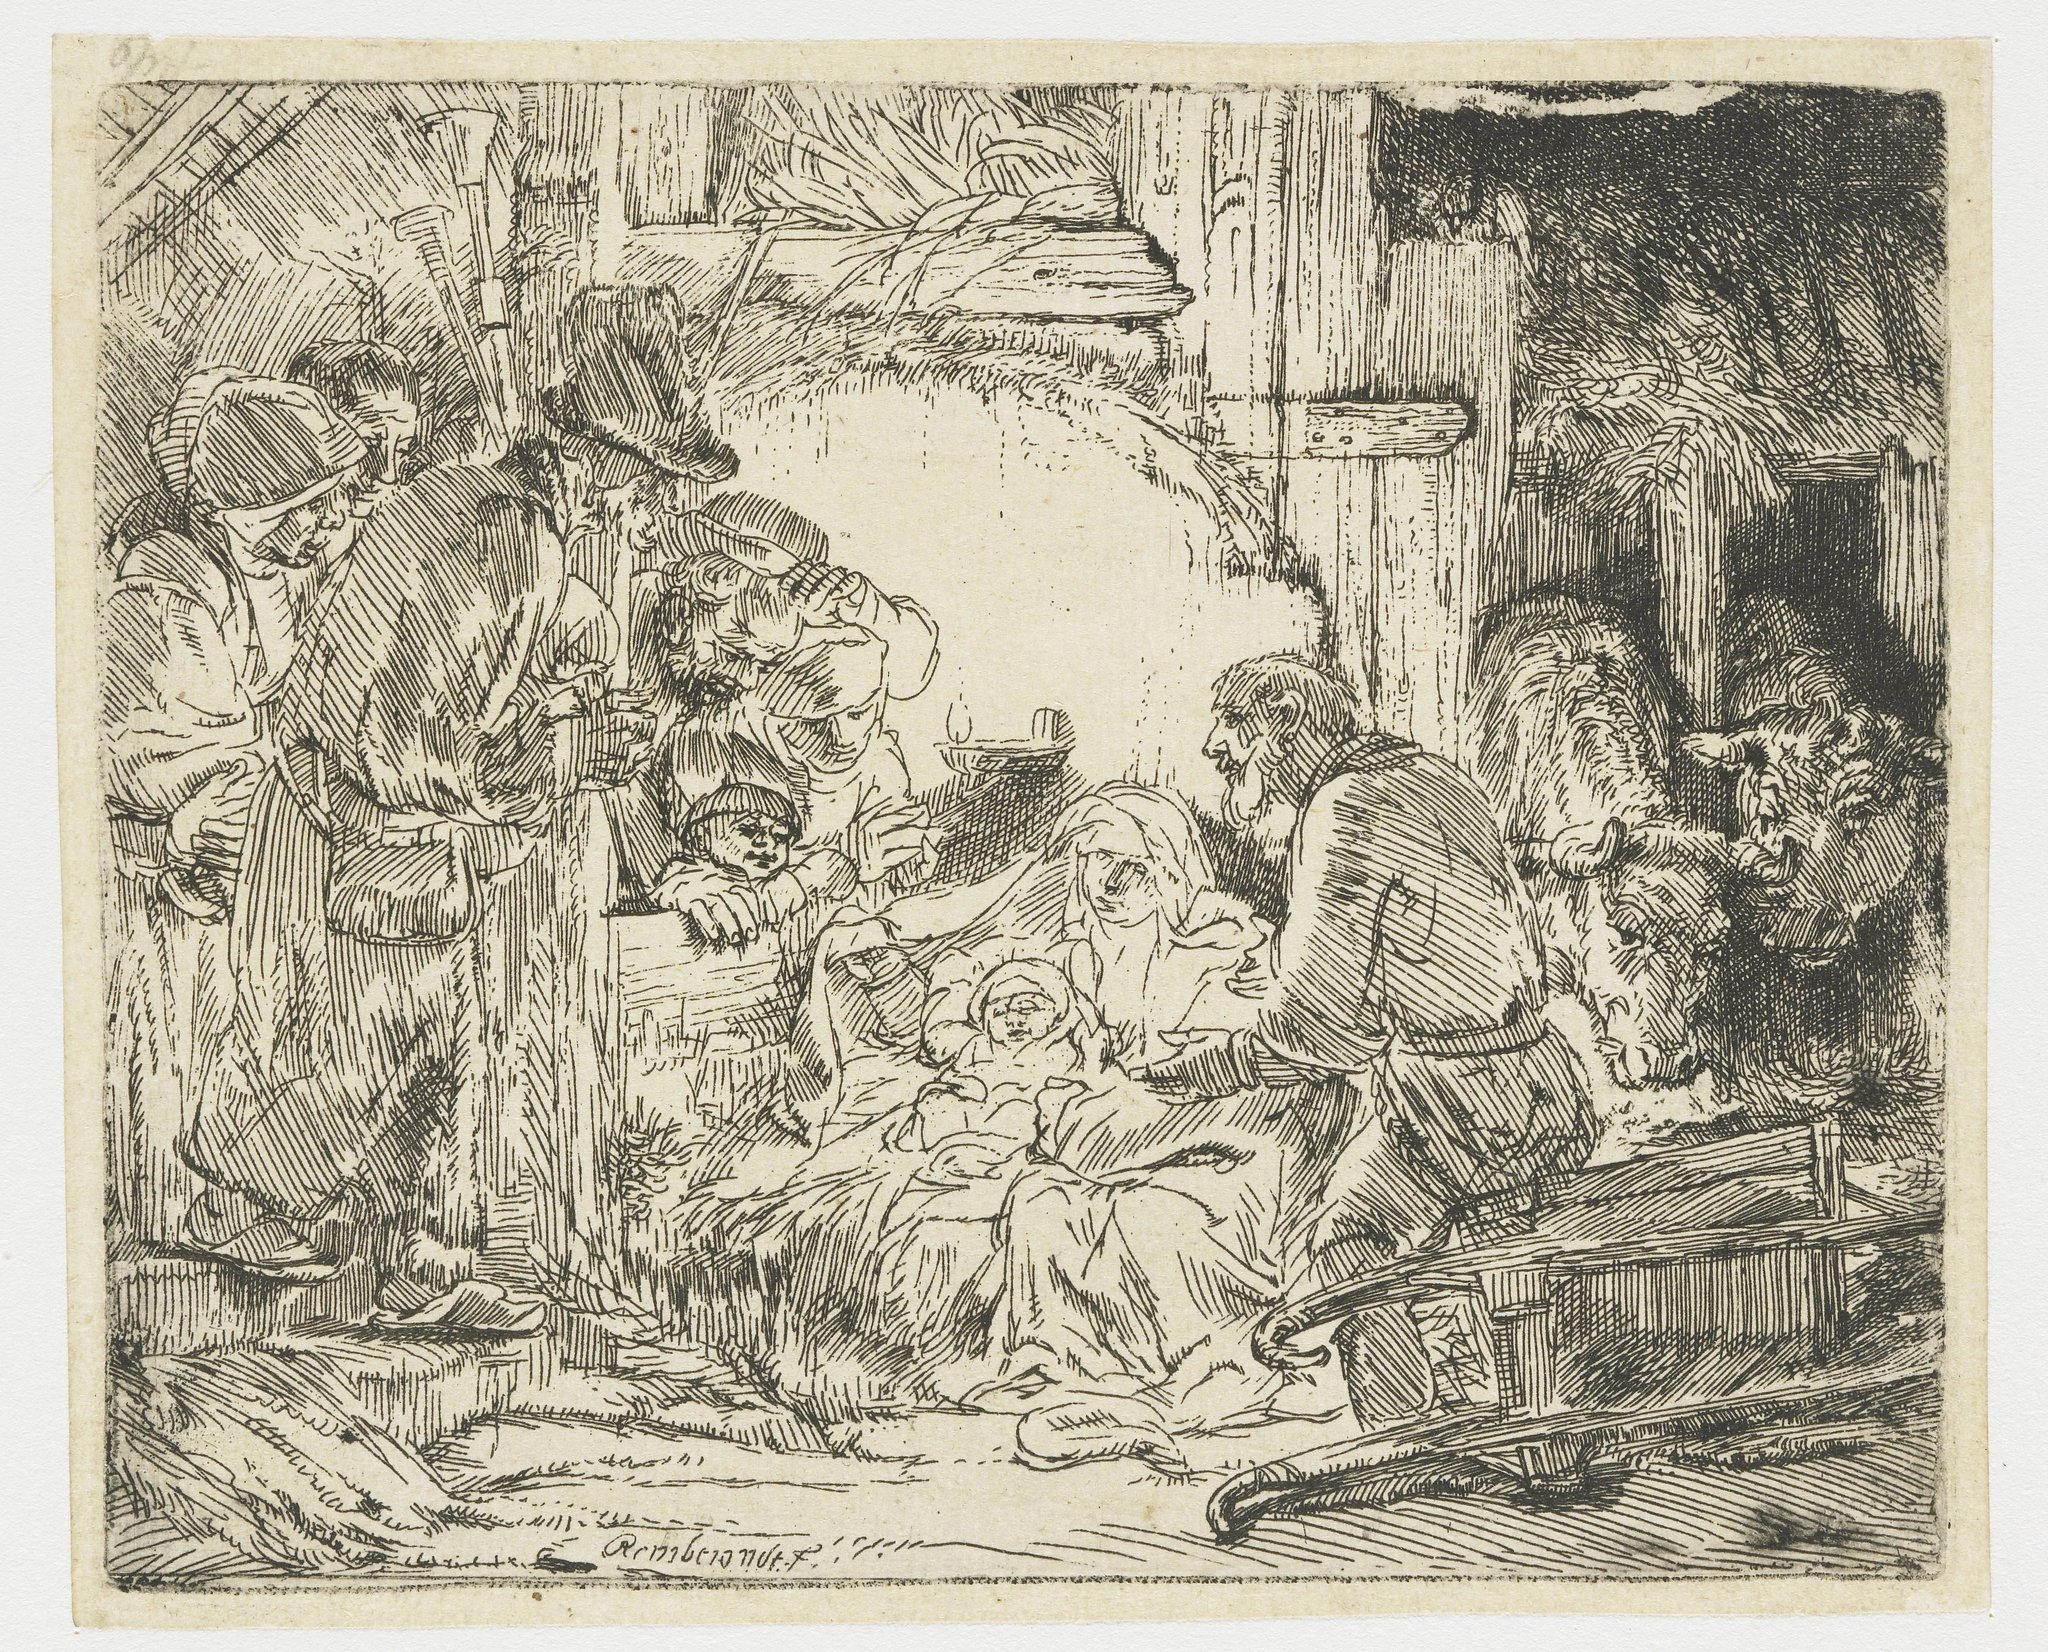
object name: print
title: The adoration of the shepherds: with the lamp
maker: rembrandt van rijn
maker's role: draughtsman, painter, print maker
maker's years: 1606-1669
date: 1654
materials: paper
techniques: drypoint, etching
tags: adoration of the christ-child by the shepherds; mary and joseph present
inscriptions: collector's mark: Lugt 2228, collector's mark: Lugt 2005, collector's mark: Lugt 1021, collector's mark: Lugt 1169 bis, signature: ‘Rembrandt f.’